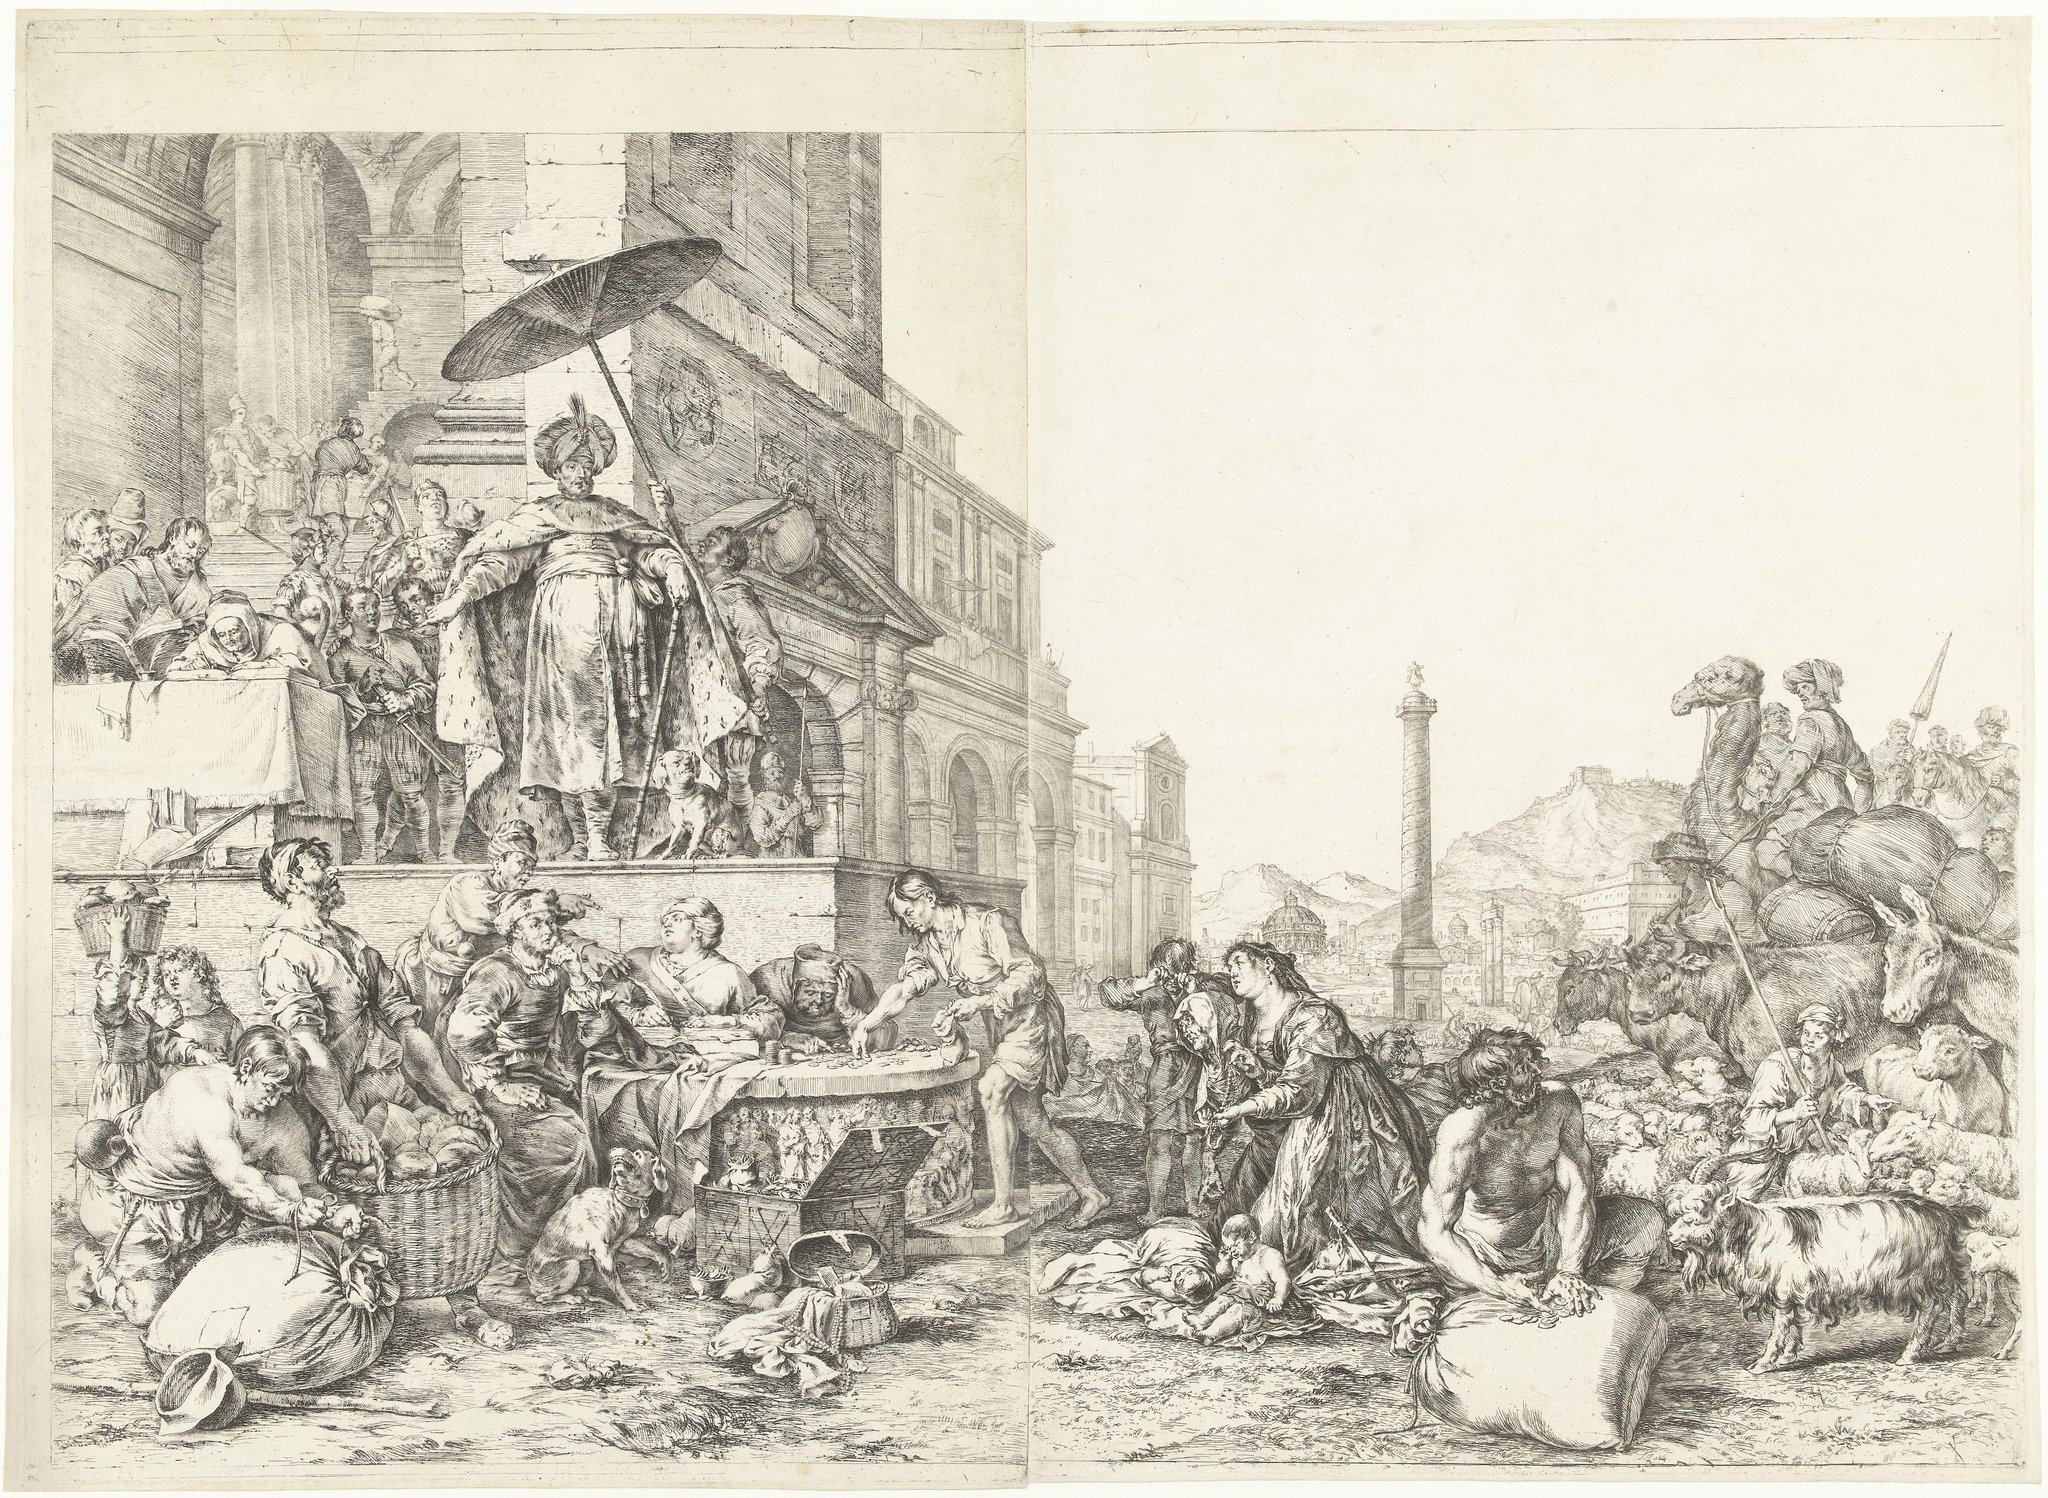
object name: print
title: Jozef verdeelt het graan in Egypte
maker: bartholomeus breenbergh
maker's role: draughtsman, print maker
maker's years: 1599-1657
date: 1609-1659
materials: paper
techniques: engraving, etching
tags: joseph opens the storehouse and sells corn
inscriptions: collector's mark: Lugt 240, collector's mark: Lugt 1838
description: Passage uit het verhaal van Jozef in Egypte (Genesis 41:55-57). Voor het paleis van de Farao staat Jozef. Hij is rijk gekleed en een slaaf houdt een parasol boven zijn hoofd. Op de voorgrond wordt graan uitgedeeld. Vrouwen en mannen betalen in geld of juwelen in ruil voor graan. Allen komen ze naar Egypte om de hongersnood te vermijden.